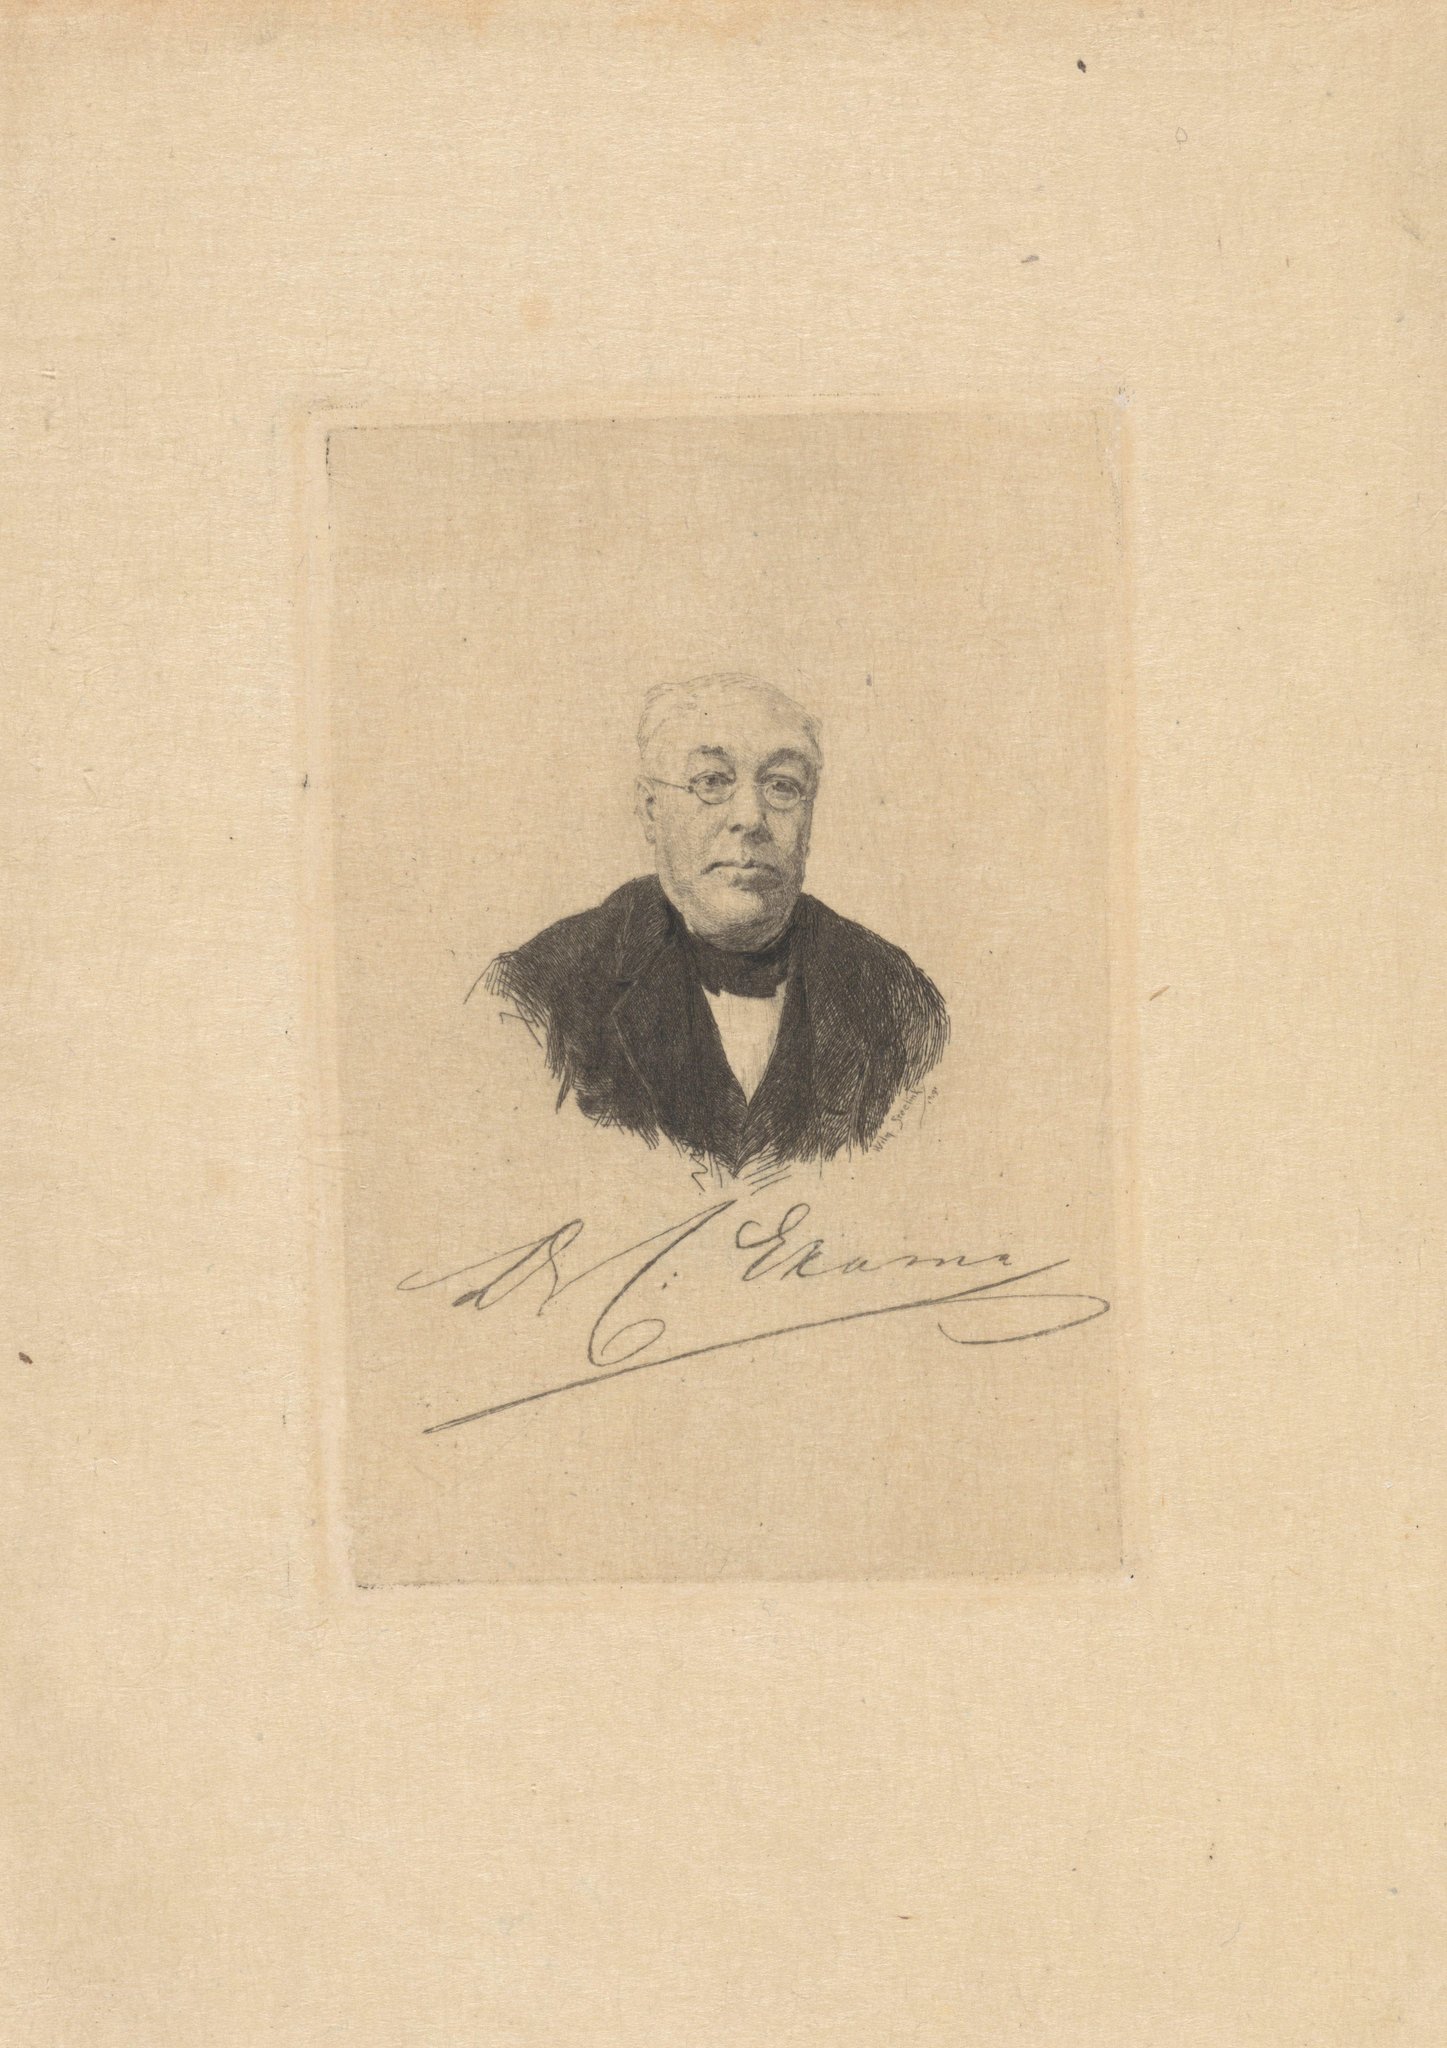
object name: print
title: Portret van Cornelius Ekama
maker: willem steelink (ii)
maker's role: draughtsman, print maker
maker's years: 1856-1928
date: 1891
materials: paper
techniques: etching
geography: netherlands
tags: leiden, haarlem, cornelius ekama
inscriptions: collector's mark: Lugt 2233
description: Portret van Cornelius Ekama arts en schrijver te Haarlem.